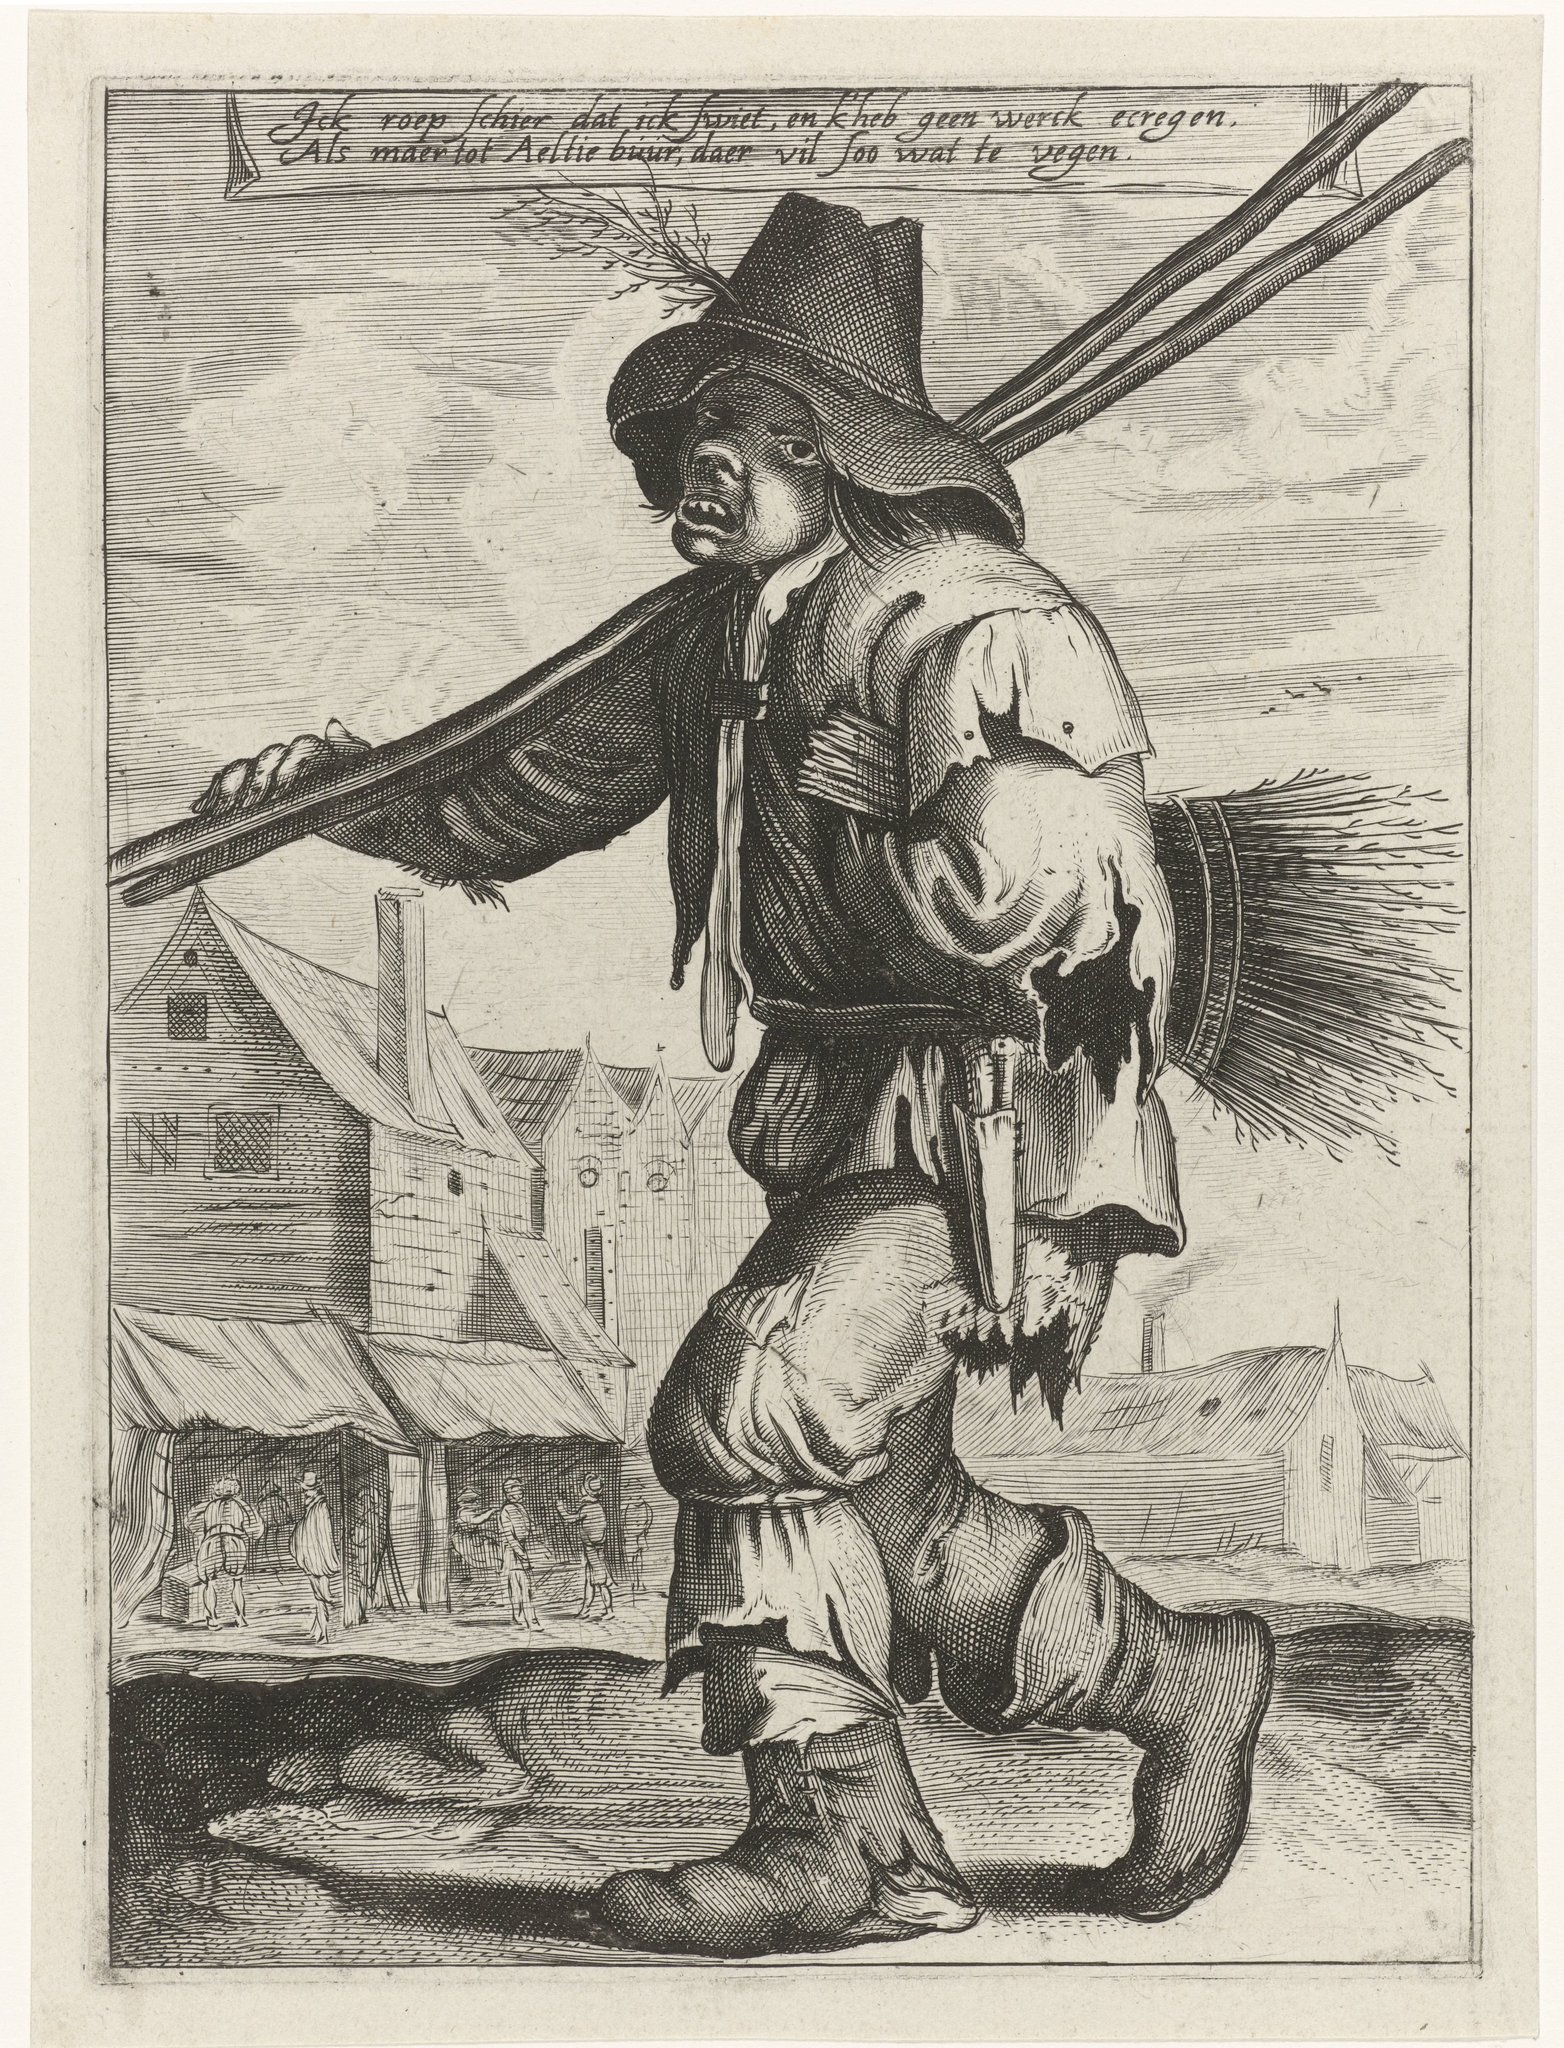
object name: print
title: Schoorsteenveger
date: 1628-1648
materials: paper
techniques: engraving, etching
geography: haarlem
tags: handicrafts ~ maintenance and repair (with name of trade or profession)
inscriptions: collector's mark: Lugt 2228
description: Een schoorsteenveger in lompen gekleed en met hoed, met stokken over de schouder en onder zijn arm een bos samengebonden takken. Op de achtergrond een dorp met figuren bij twee marktkramen.